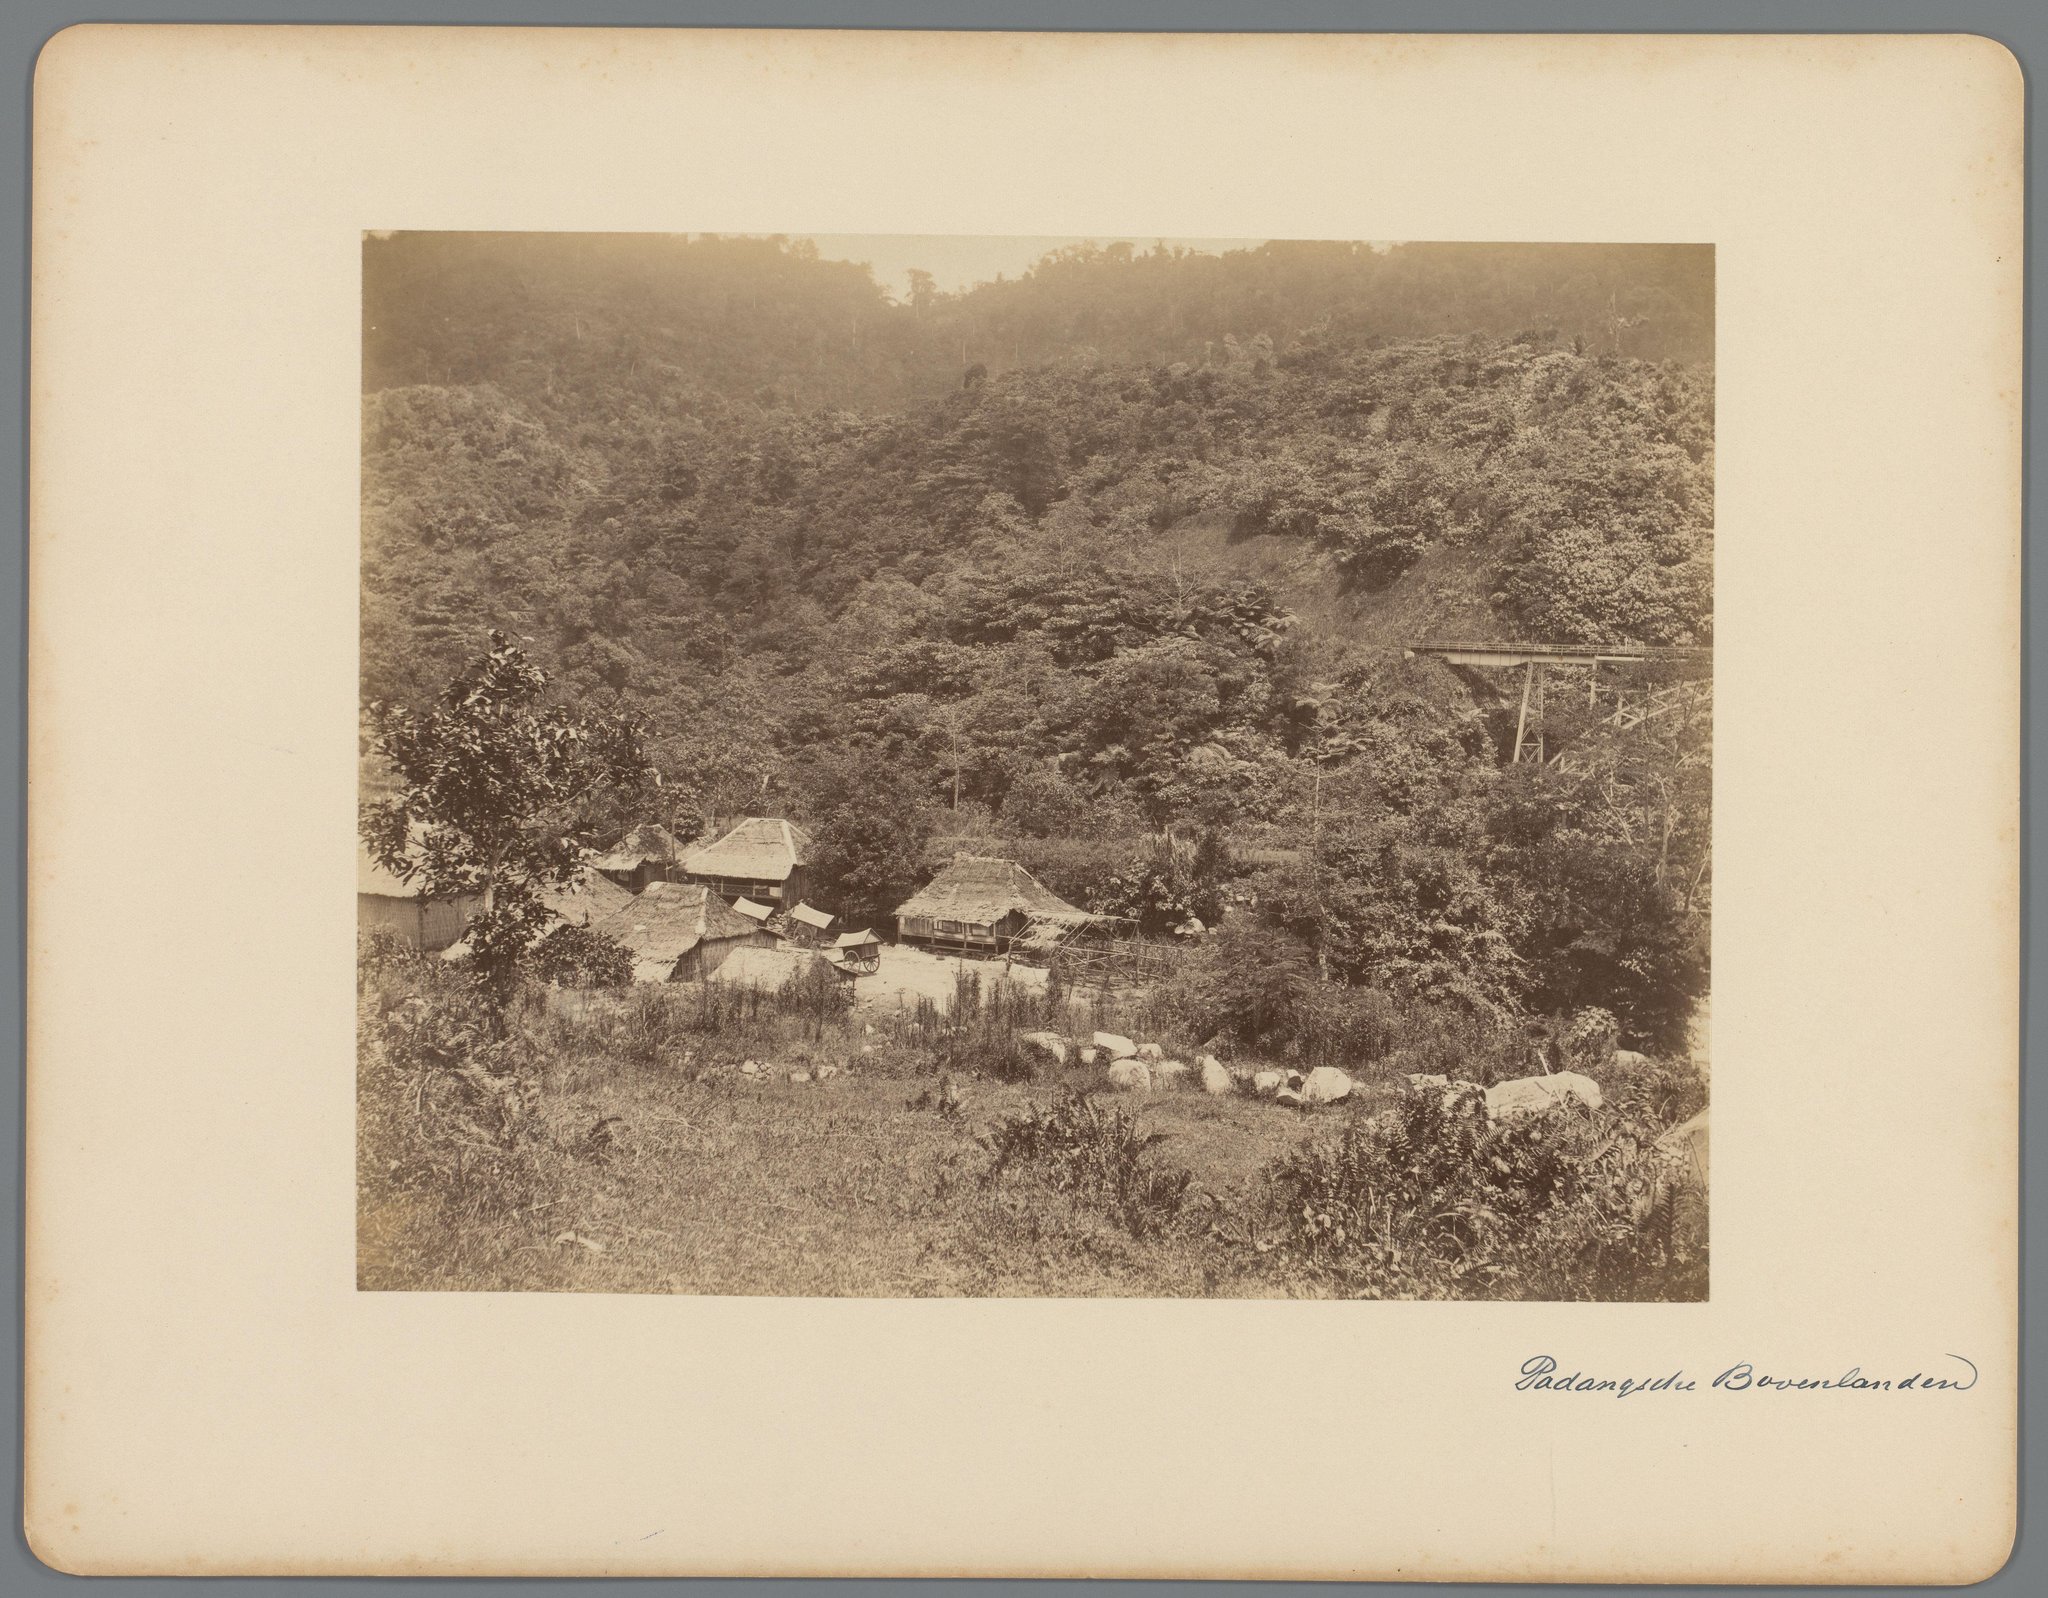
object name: photograph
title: Gezicht op een dorp in een vallei op West-Sumatra met rechts een deel van een spoorbrug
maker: christiaan benjamin nieuwenhuis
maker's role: publisher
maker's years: 1863-1922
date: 1891-1900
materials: cardboard, paper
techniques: albumen print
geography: sumatera barat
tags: dale, valley, village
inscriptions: inscription: ‘FOTO’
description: Deze foto zat oorspronkelijk in prentenkabinet RP-F-AA3192.